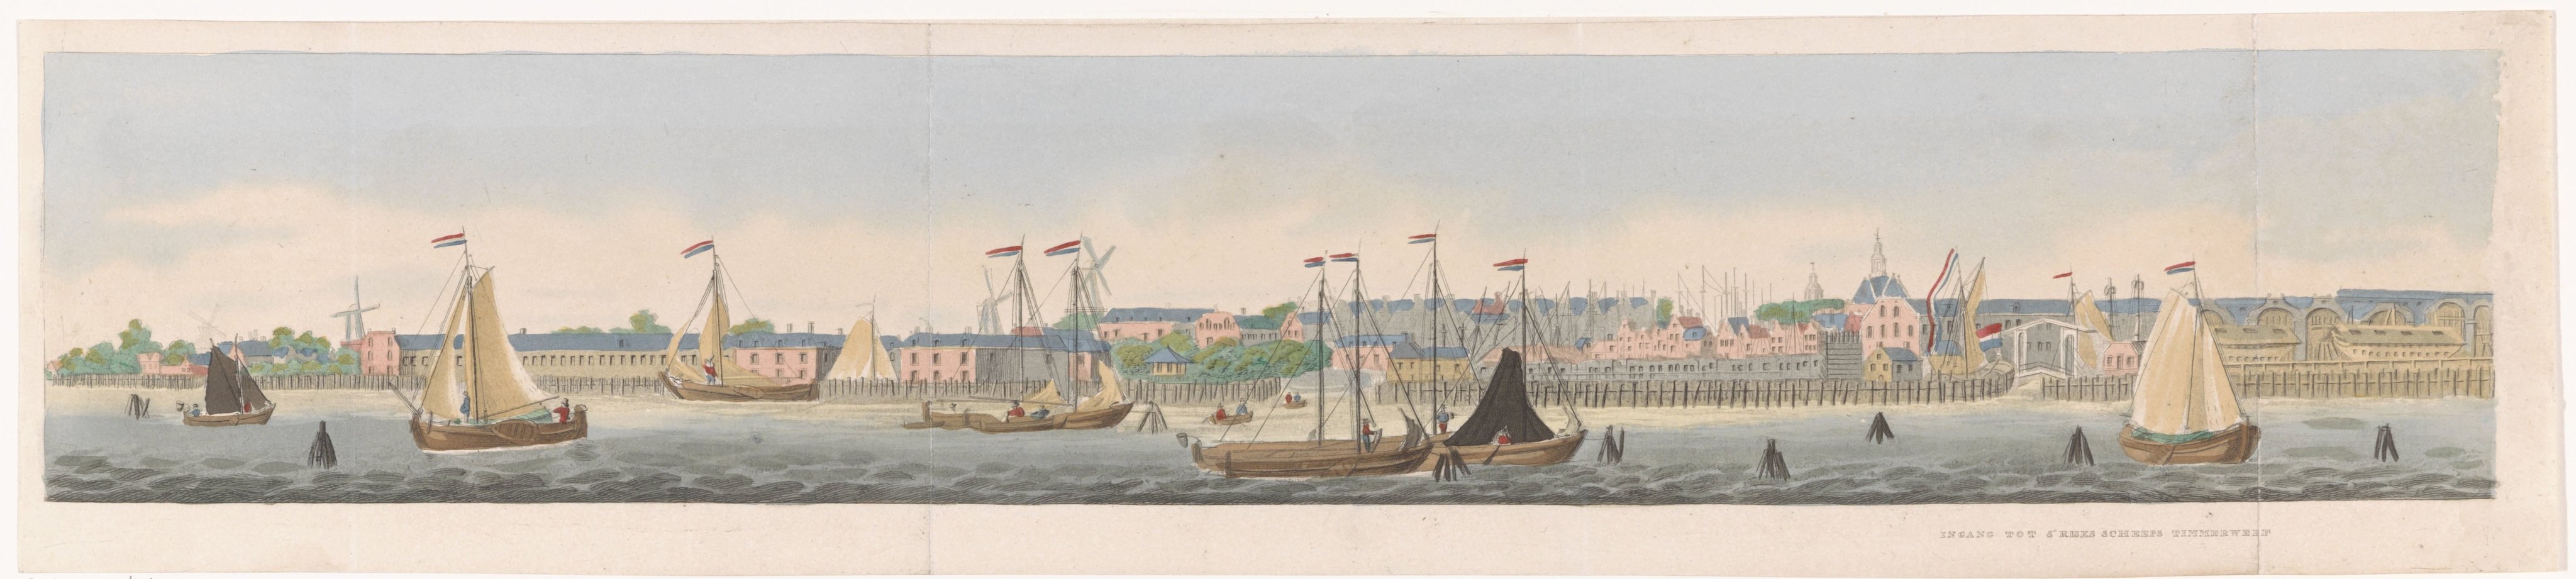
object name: print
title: Panorama van Amsterdam (blad A)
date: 1792-1847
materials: paper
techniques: aquatint, engraving, etching, hand coloring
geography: amsterdam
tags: prospect of city, town panorama, silhouette of city, amsterdam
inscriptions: collector's mark: Lugt 2228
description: Gezicht vanaf het IJ op de scheepswerven op Oostenburg in Amsterdam. Op de voorgrond schepen.